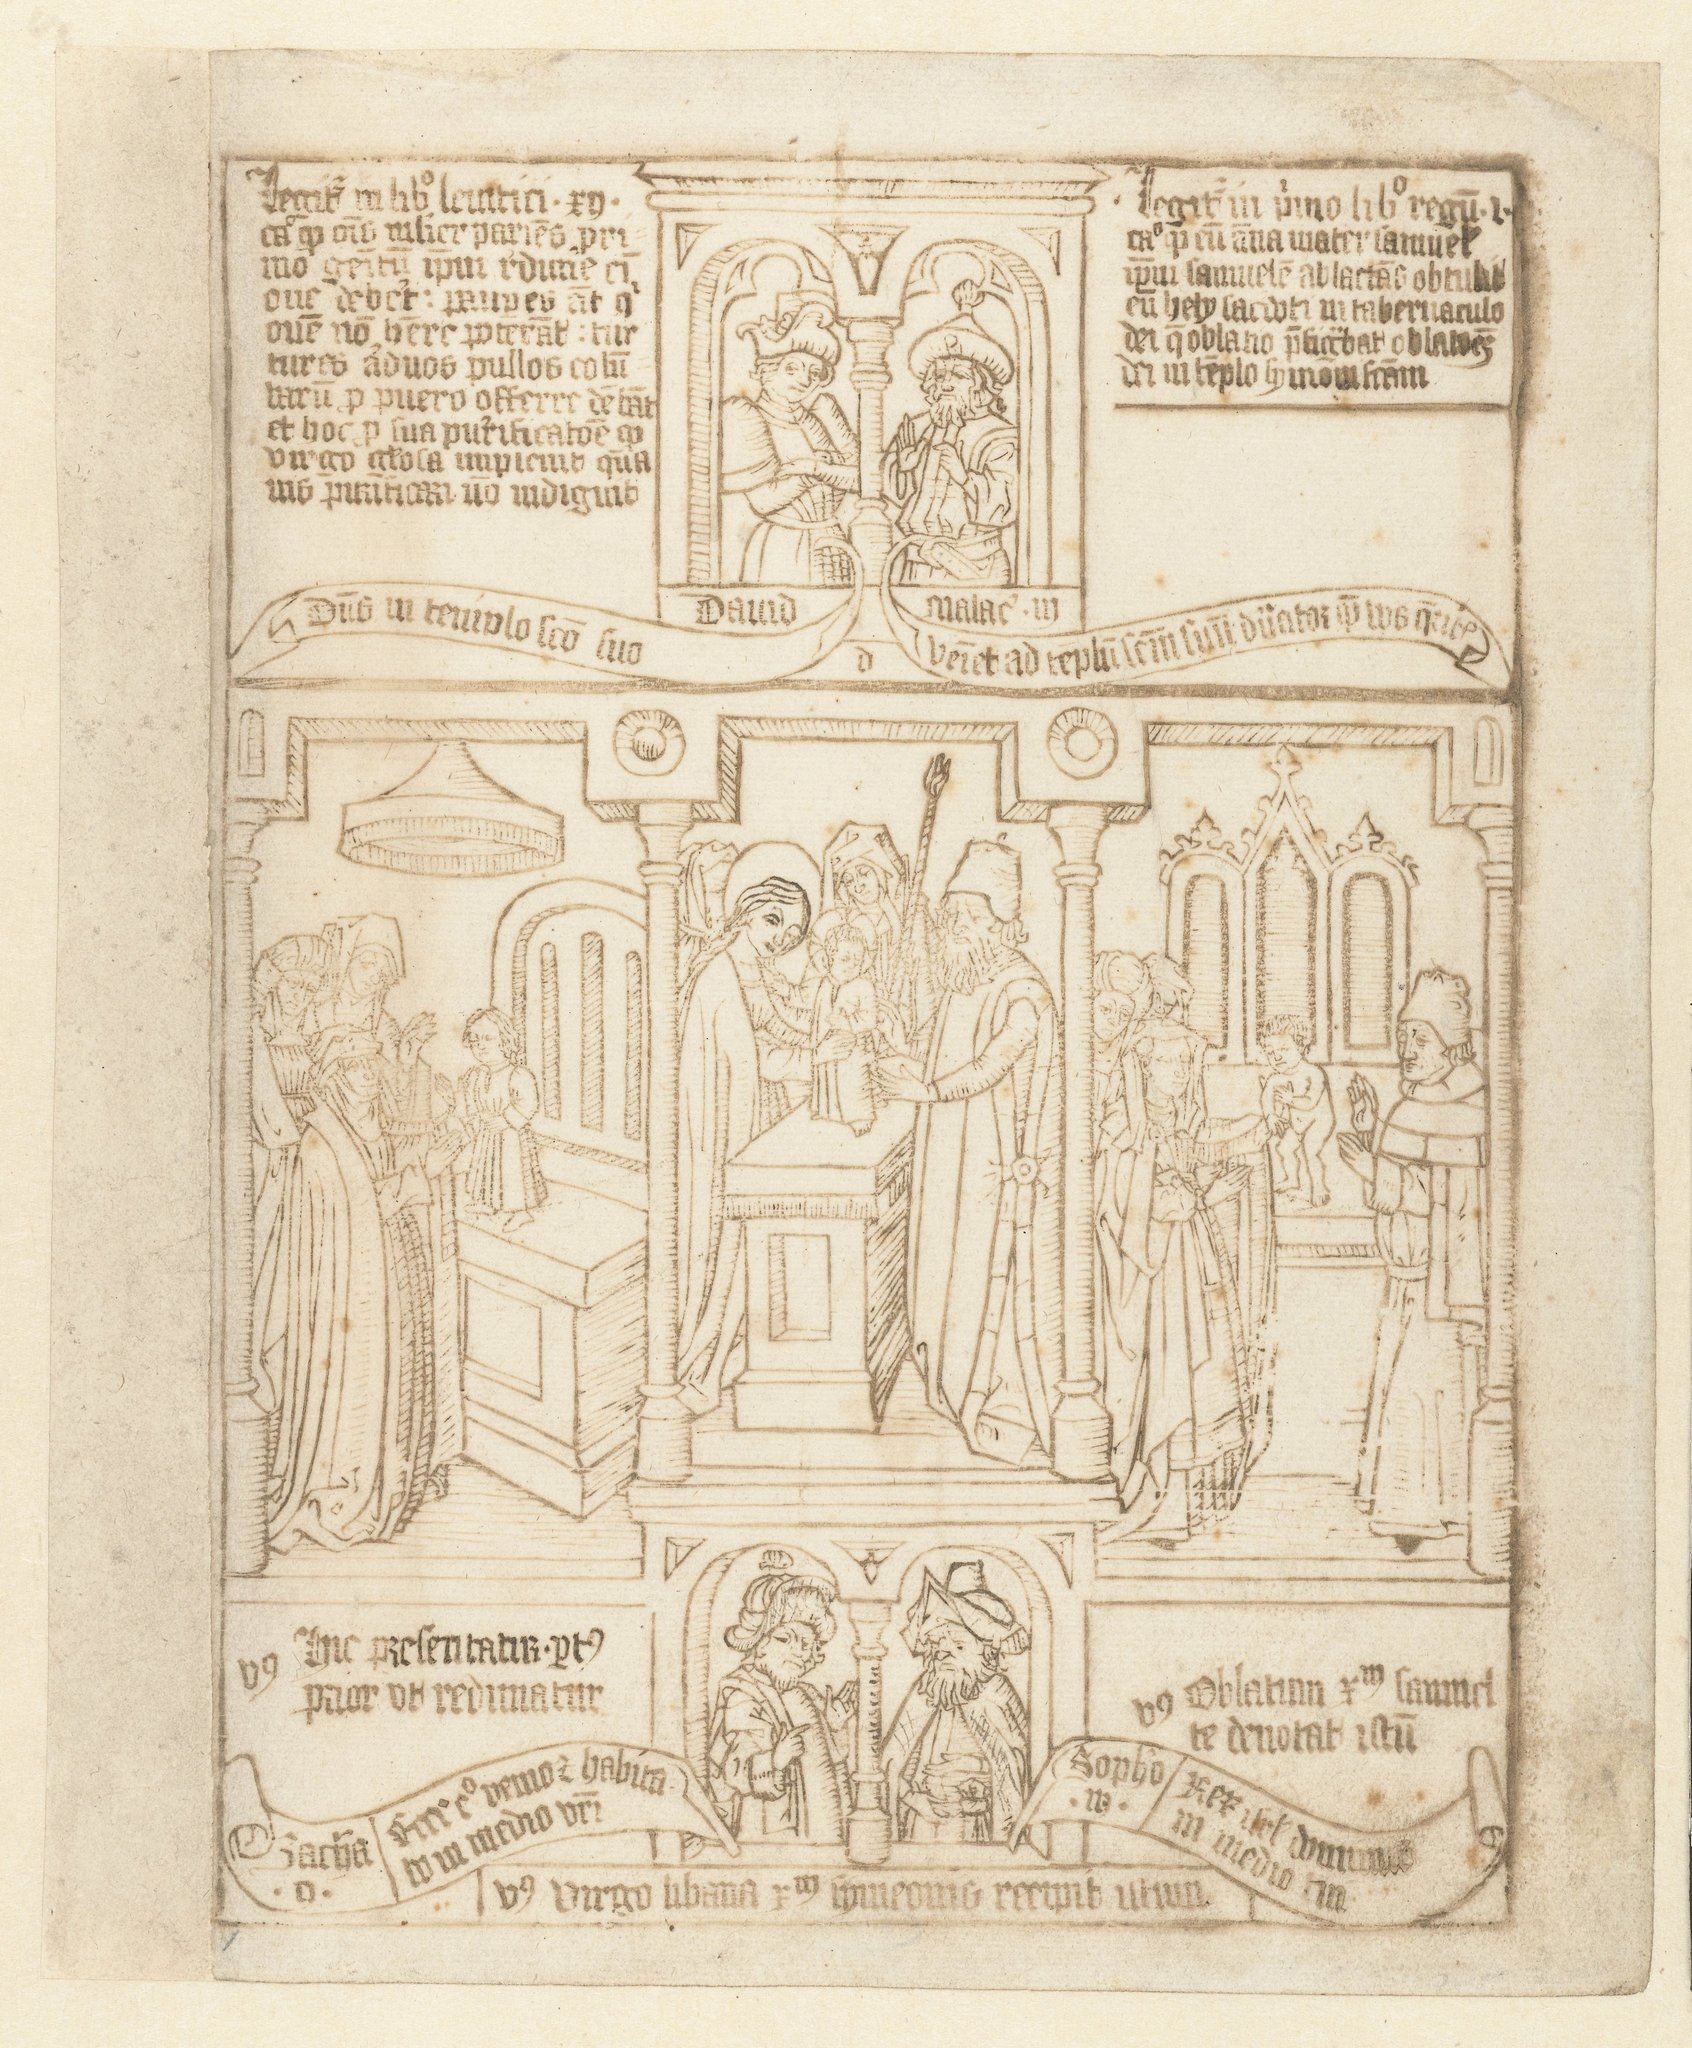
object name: book illustration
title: Blad d. uit een Biblia Pauperum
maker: Anonymous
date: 1460-1480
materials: paper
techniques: woodcut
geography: low countries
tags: samuel in the temple at shiloh presented to eli by hannah, prophets, sibyls, evangelists, doctors of the church; persons ~ the bible (not in biblical context), presentation of the christ-child in the temple, usually simeon (and anna) present (luke 2:22-39)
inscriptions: collector's mark: Lugt 2228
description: Voorstelling met drie presentaties in de tempel in een architectonisch kader. Links de presentatie van een eerstgeborene in de tempel, in het midden die van Christus, rechts die van Samuel. Vier profeten zijn afgebeeld boven en onder de voorstelling van Christus.